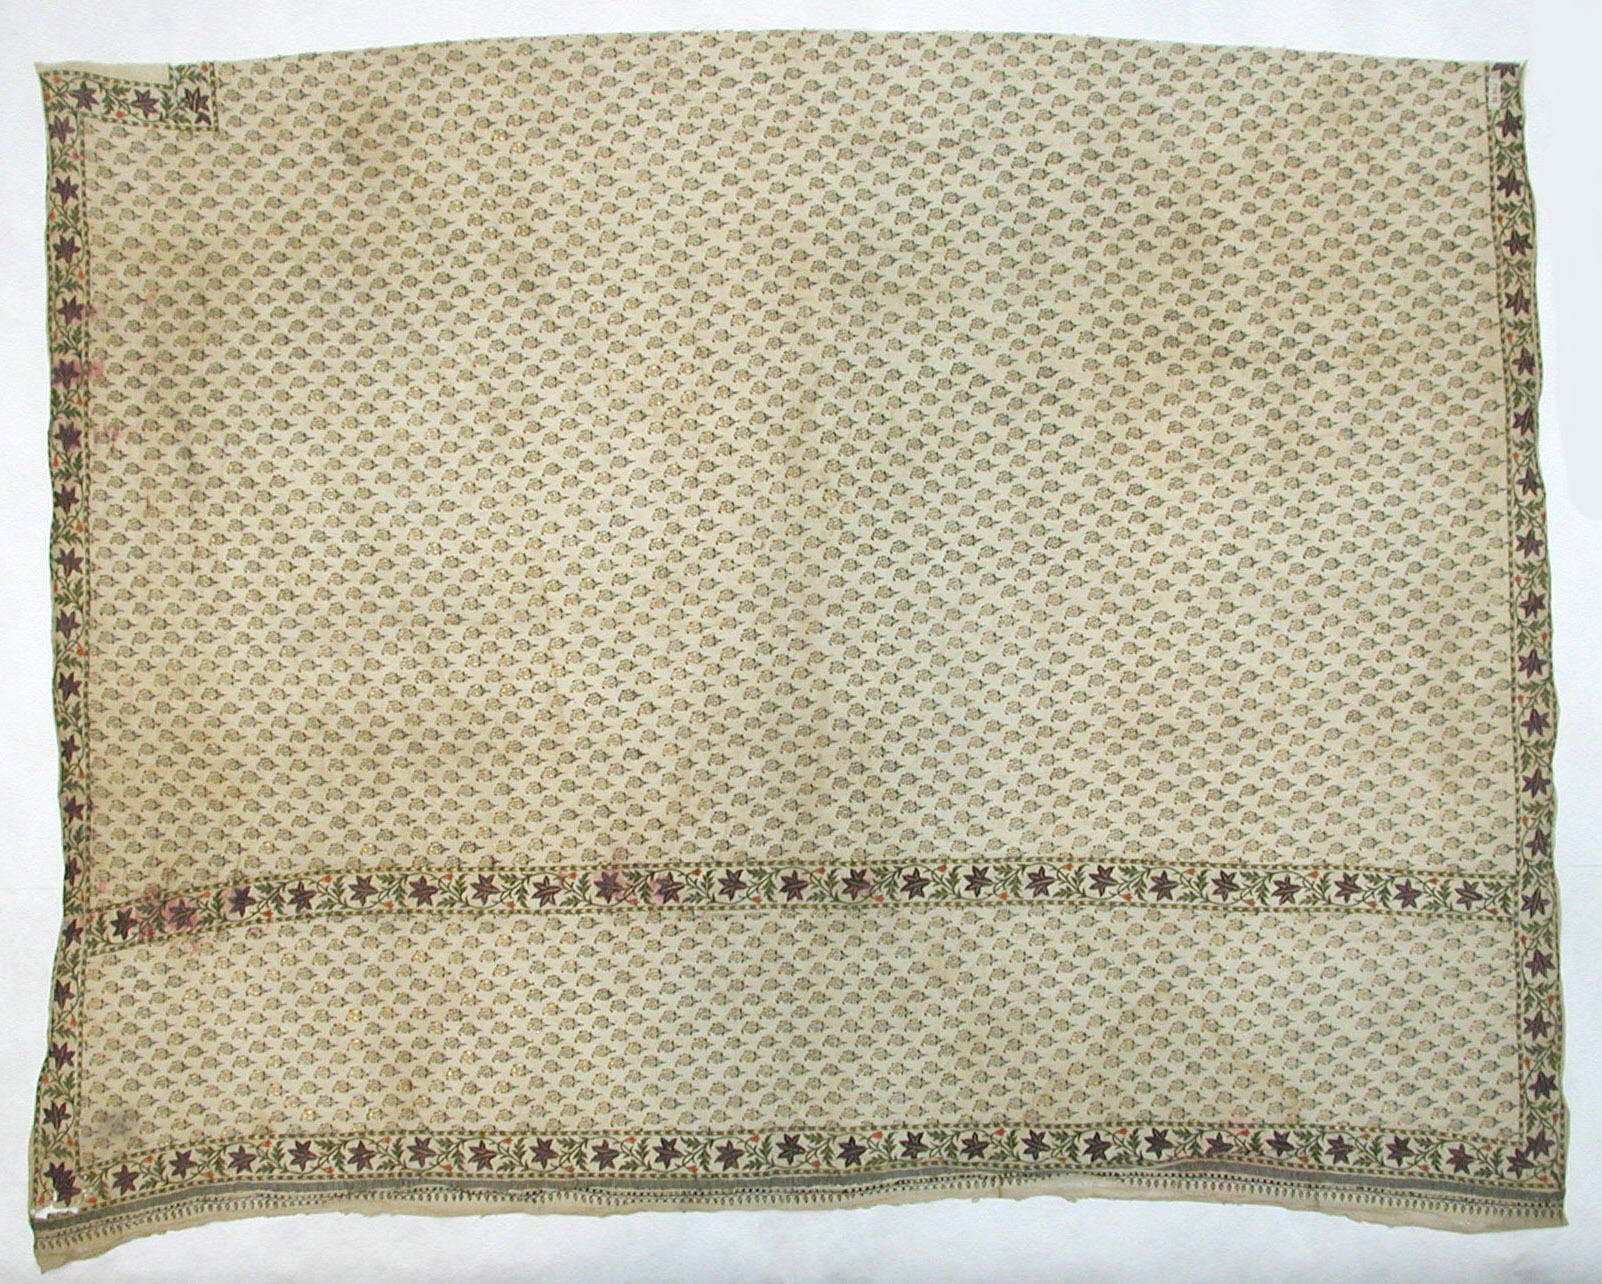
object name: textile fragment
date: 1701-1800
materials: cotton, metal thread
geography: india